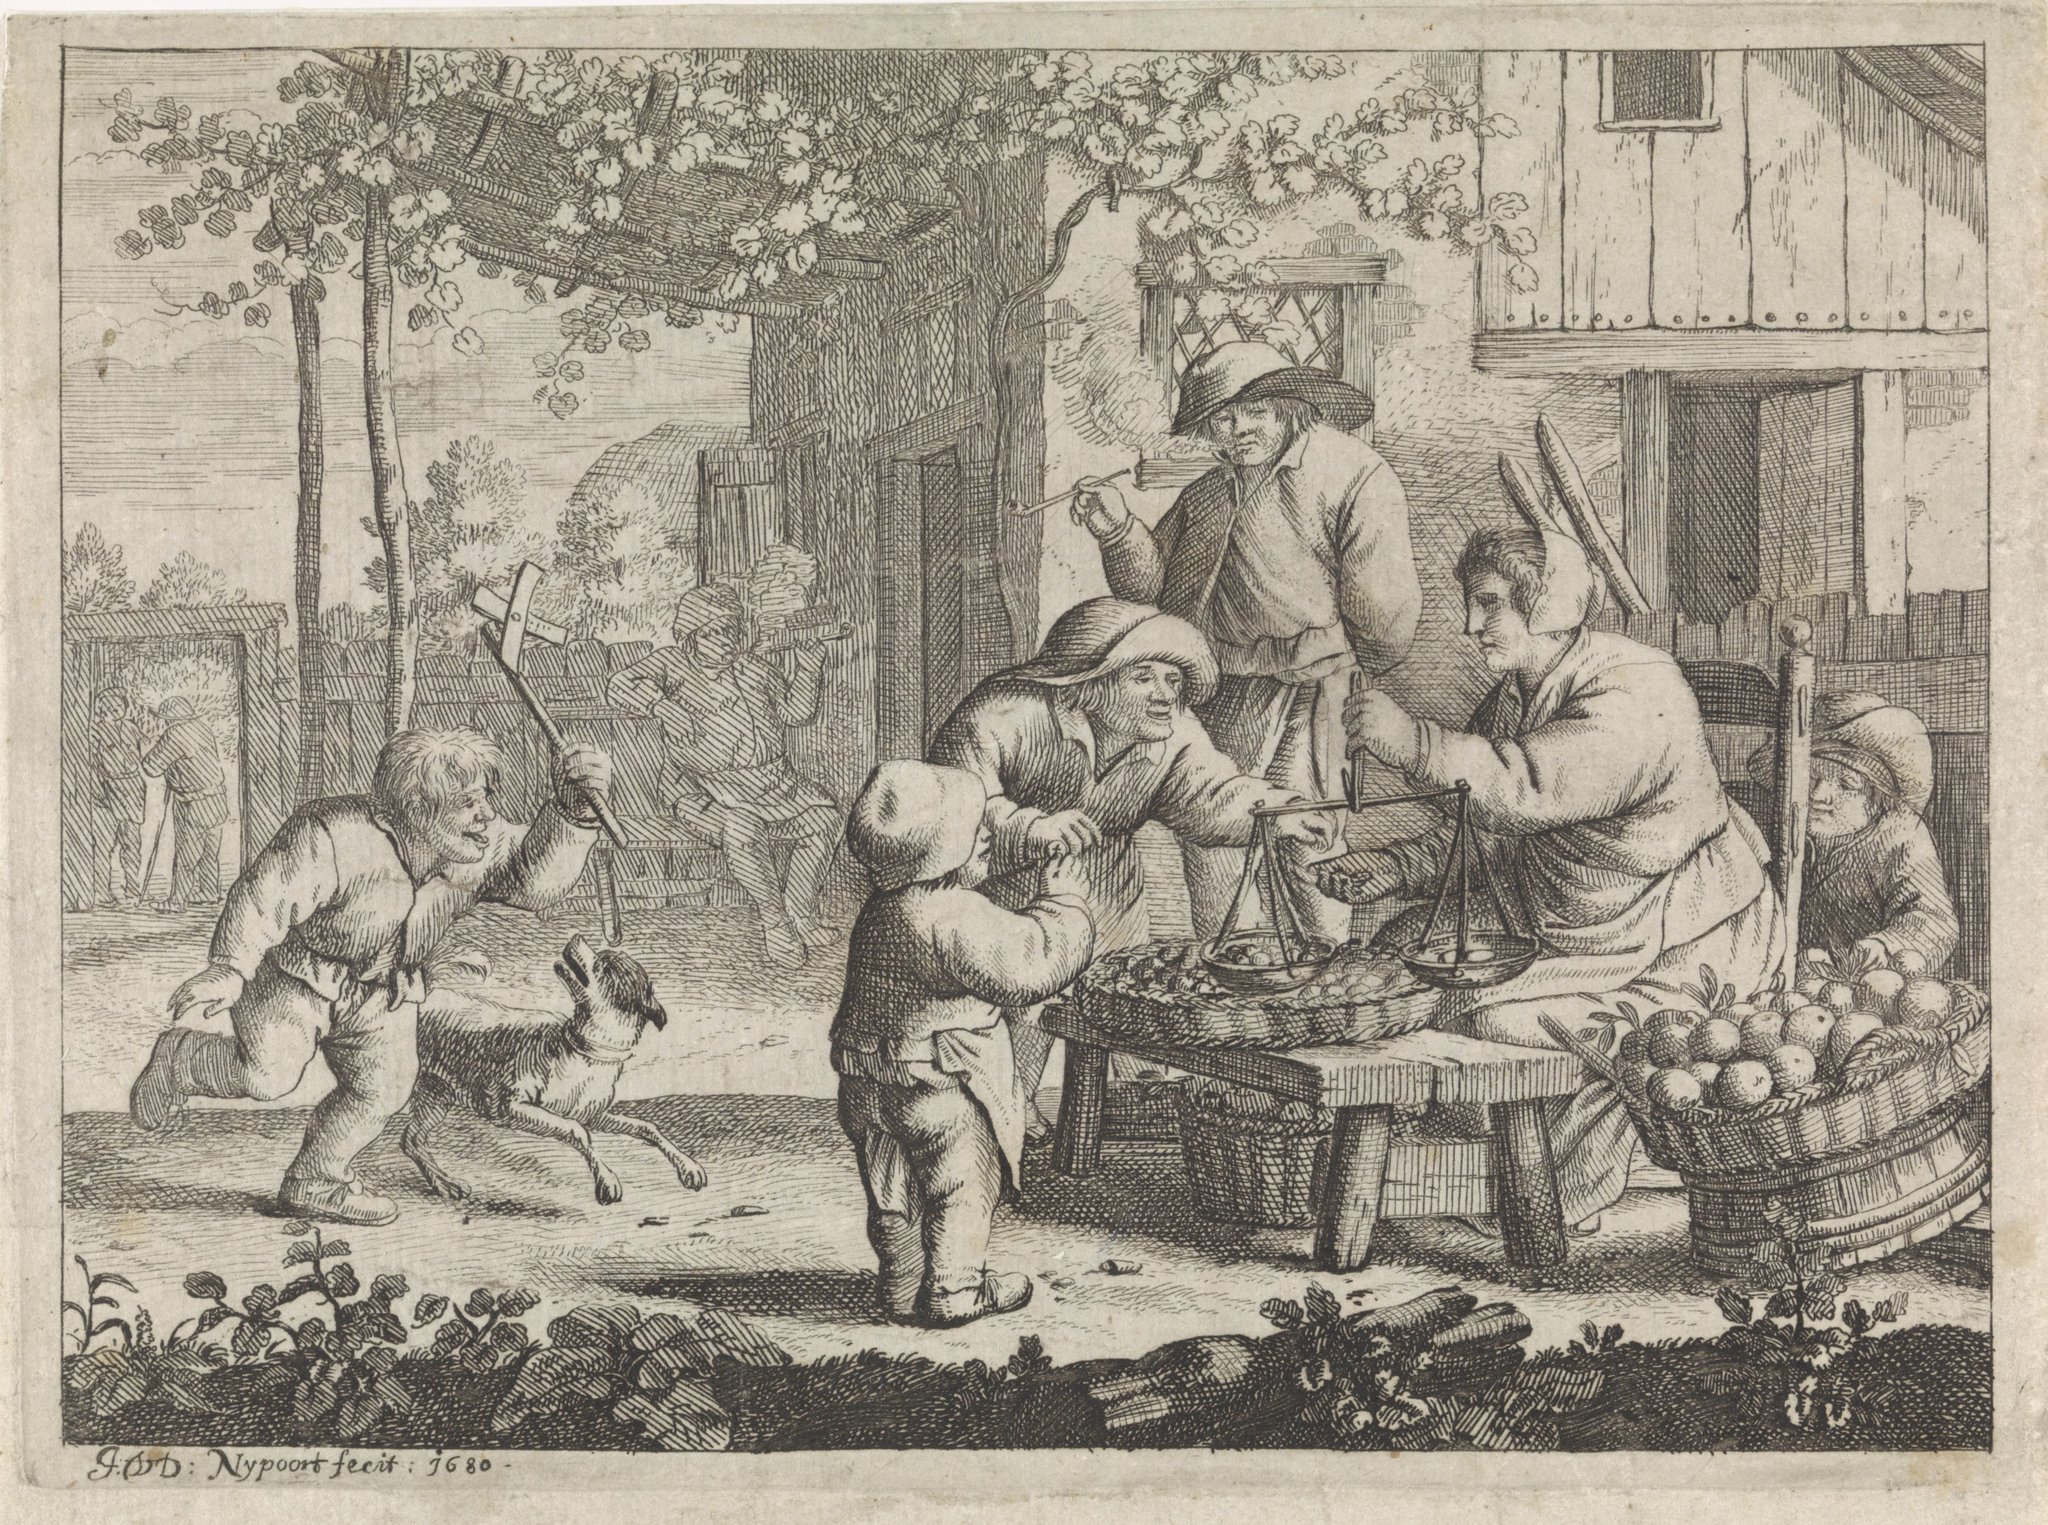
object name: print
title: Appelverkoopster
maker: justus van den nijpoort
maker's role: draughtsman, print maker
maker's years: 1625-1692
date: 1680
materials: paper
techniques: engraving, etching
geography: bogenšperk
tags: fruits: apple, scales, pipe ~ tobacco, buying and selling, dog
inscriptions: collector's mark: Lugt 2760, collector's mark: Lugt 2228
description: Een verkoopster van appels, die in de mand naast haar staan, weegt de koopwaren, terwijl een man haar betaald. Achter haar stoel probeert een jongen een appel te stelen. Links komt een jongen met een hond aanrennen, terwijl hij een windmolentje in de hand houdt. Een man met een pijp kijkt naar de verkoop.